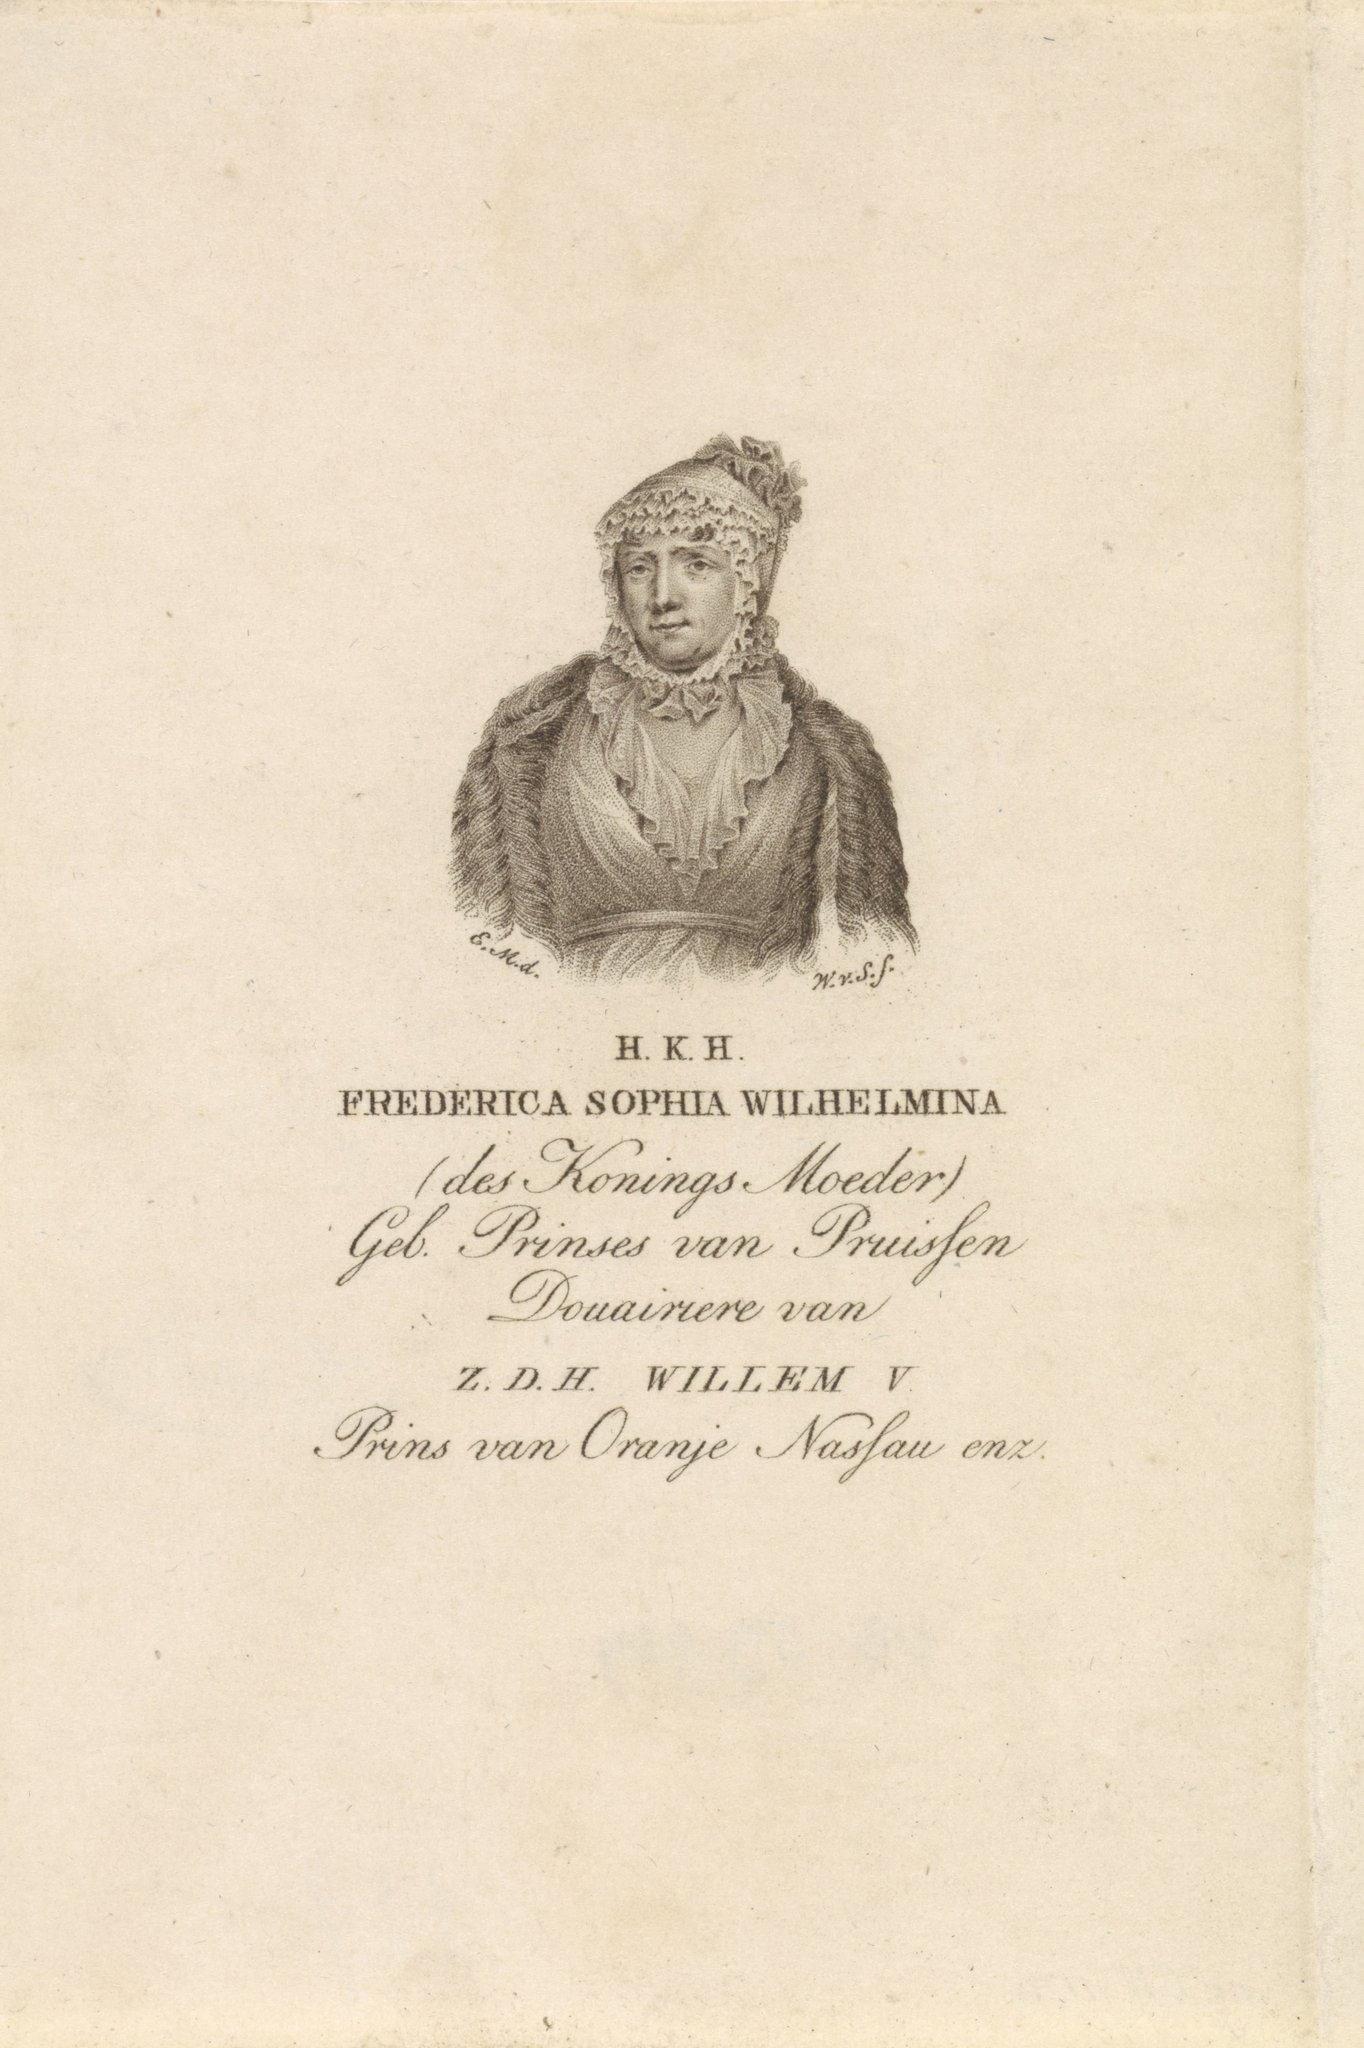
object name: print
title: Portret van Wilhelmina van Pruisen (1751-1820)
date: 1783-1851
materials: paper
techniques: etching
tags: painter, draughtsman, wilhelmina of prussia (princess of orange)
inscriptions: collector's mark: Lugt 2228